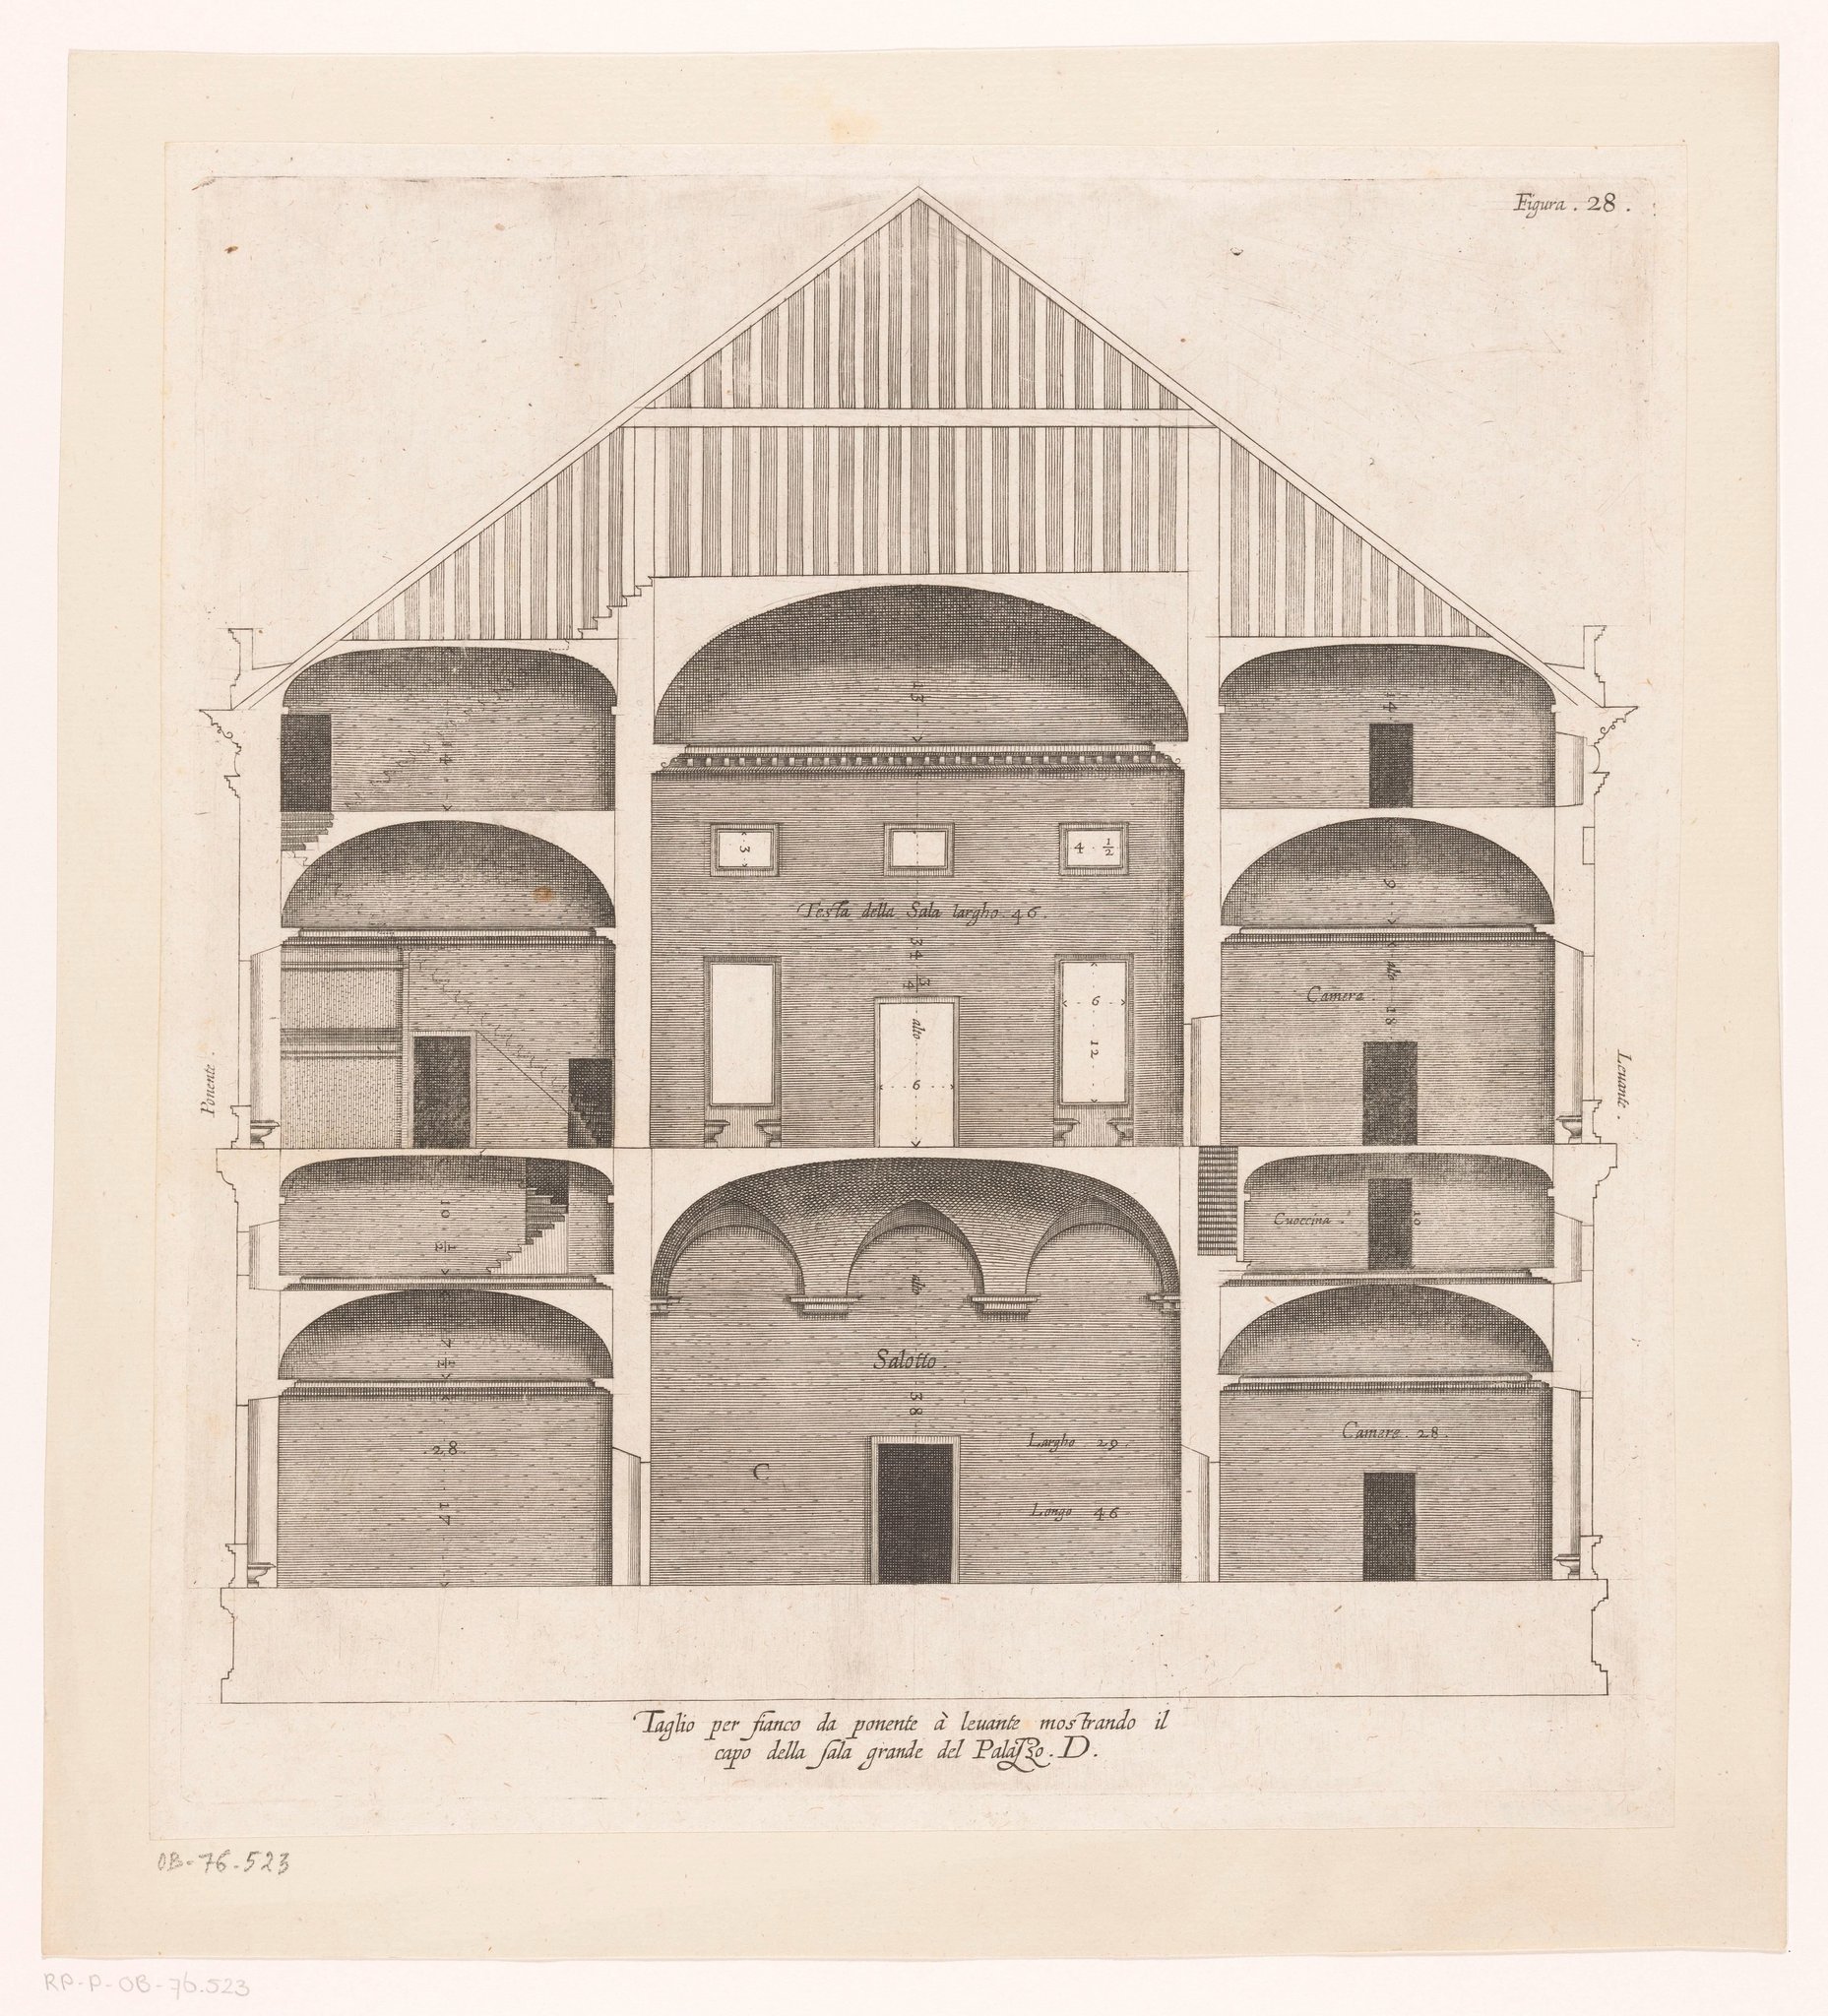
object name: print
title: Palazzi di Genova / Palazzi Antichi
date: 1622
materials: paper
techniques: engraving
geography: antwerp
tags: hôtel, i.e. small palace in city - aa - civic architecture: inside, section ~ architectural design or model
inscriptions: collector's mark: Lugt 240